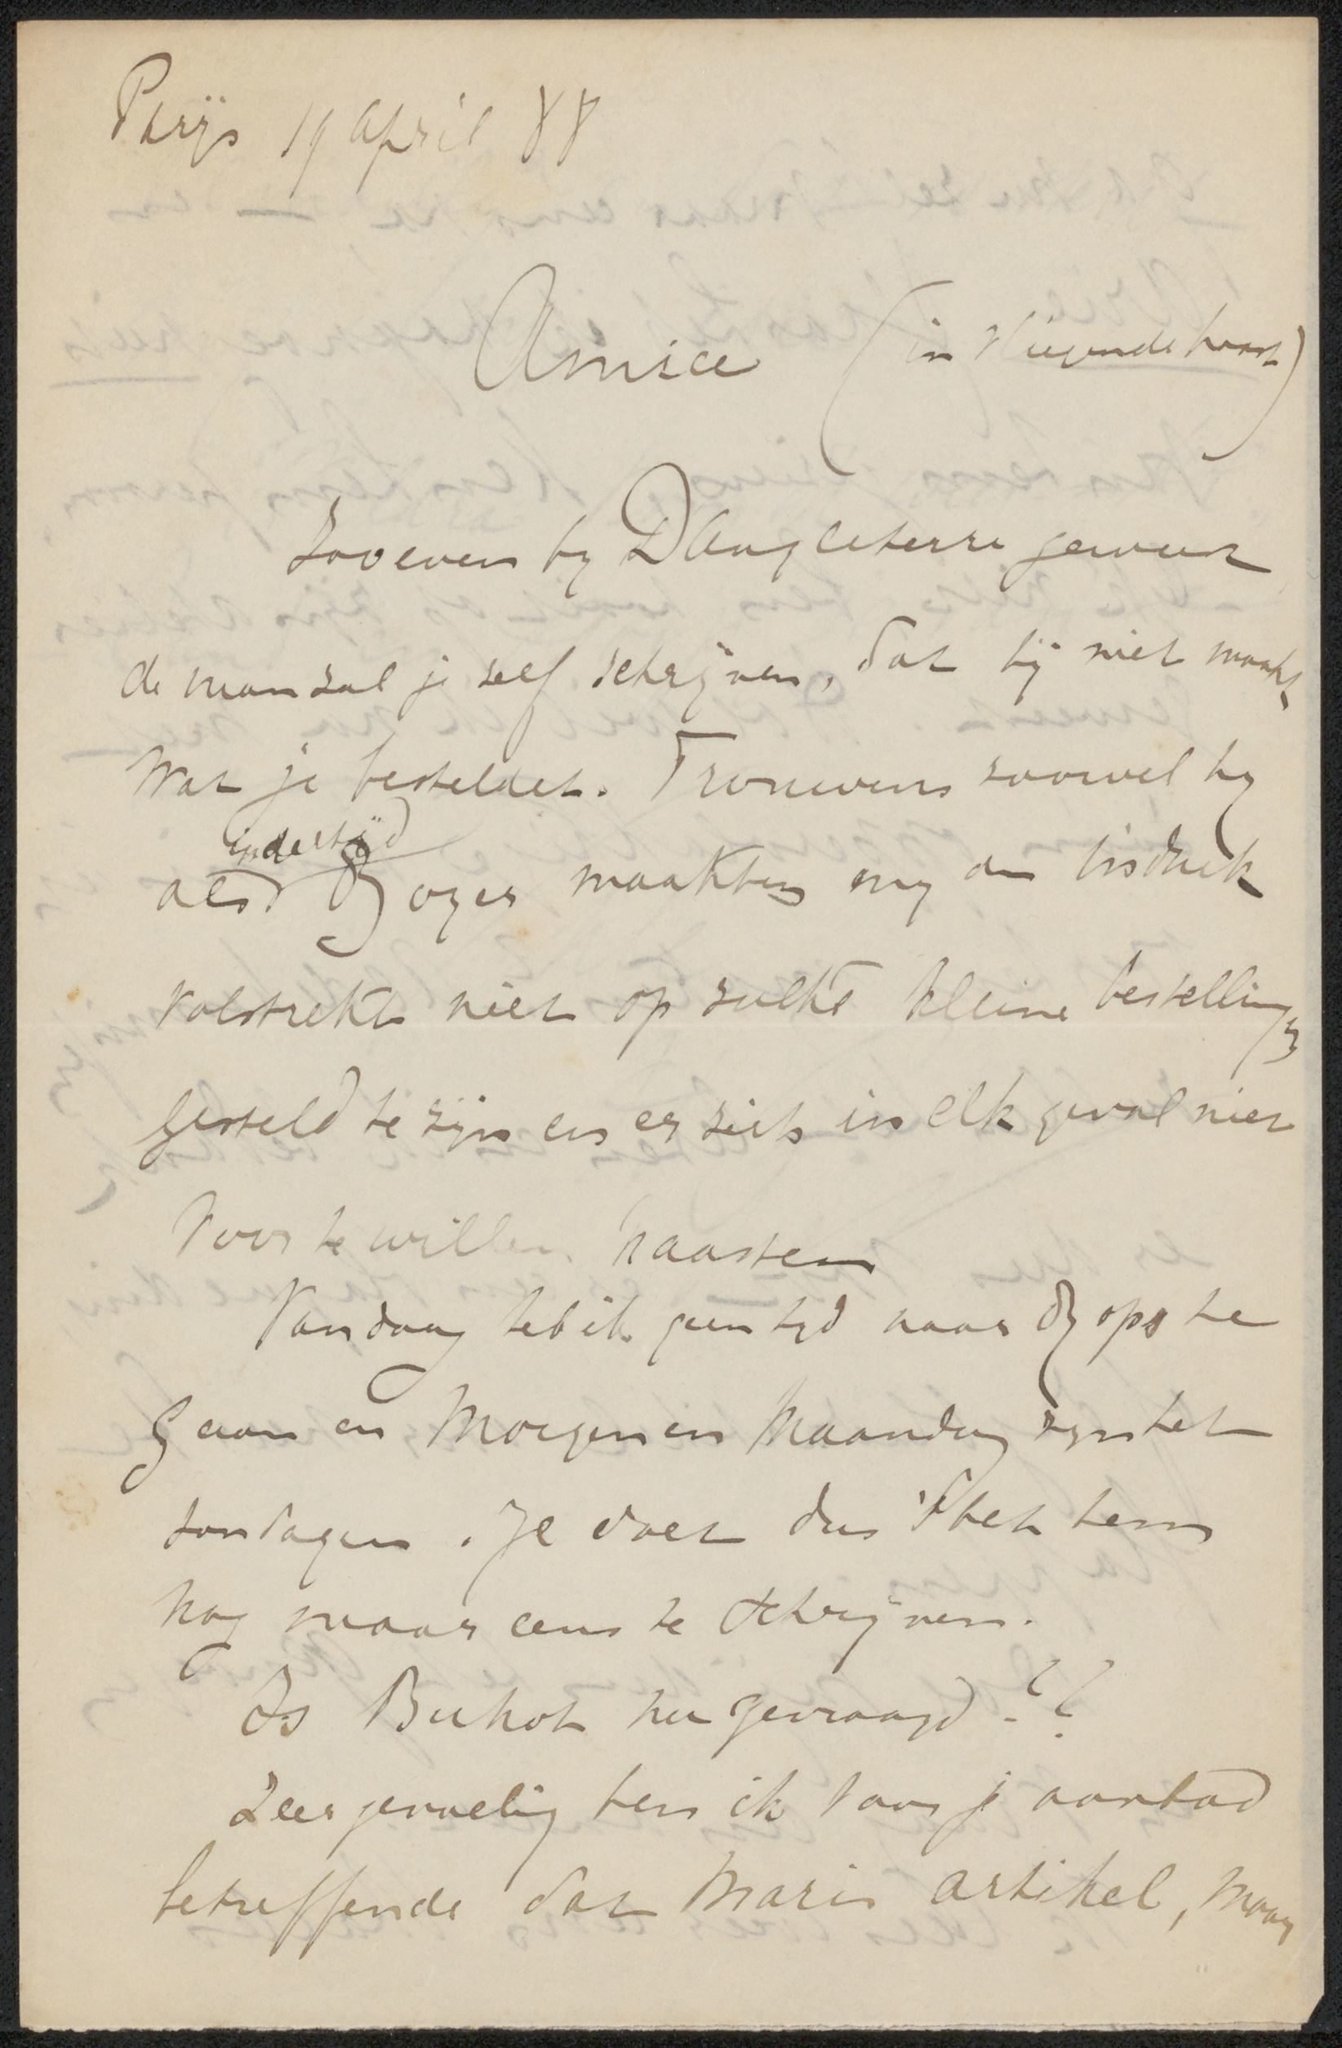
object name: letter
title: Brief aan Philip Zilcken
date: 1888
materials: ink, paper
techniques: pen, writing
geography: paris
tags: paris, print maker, draughtsman, félix hilaire buhot, félicien rops, painter, philip zilcken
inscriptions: collector's mark: ‘RPK’